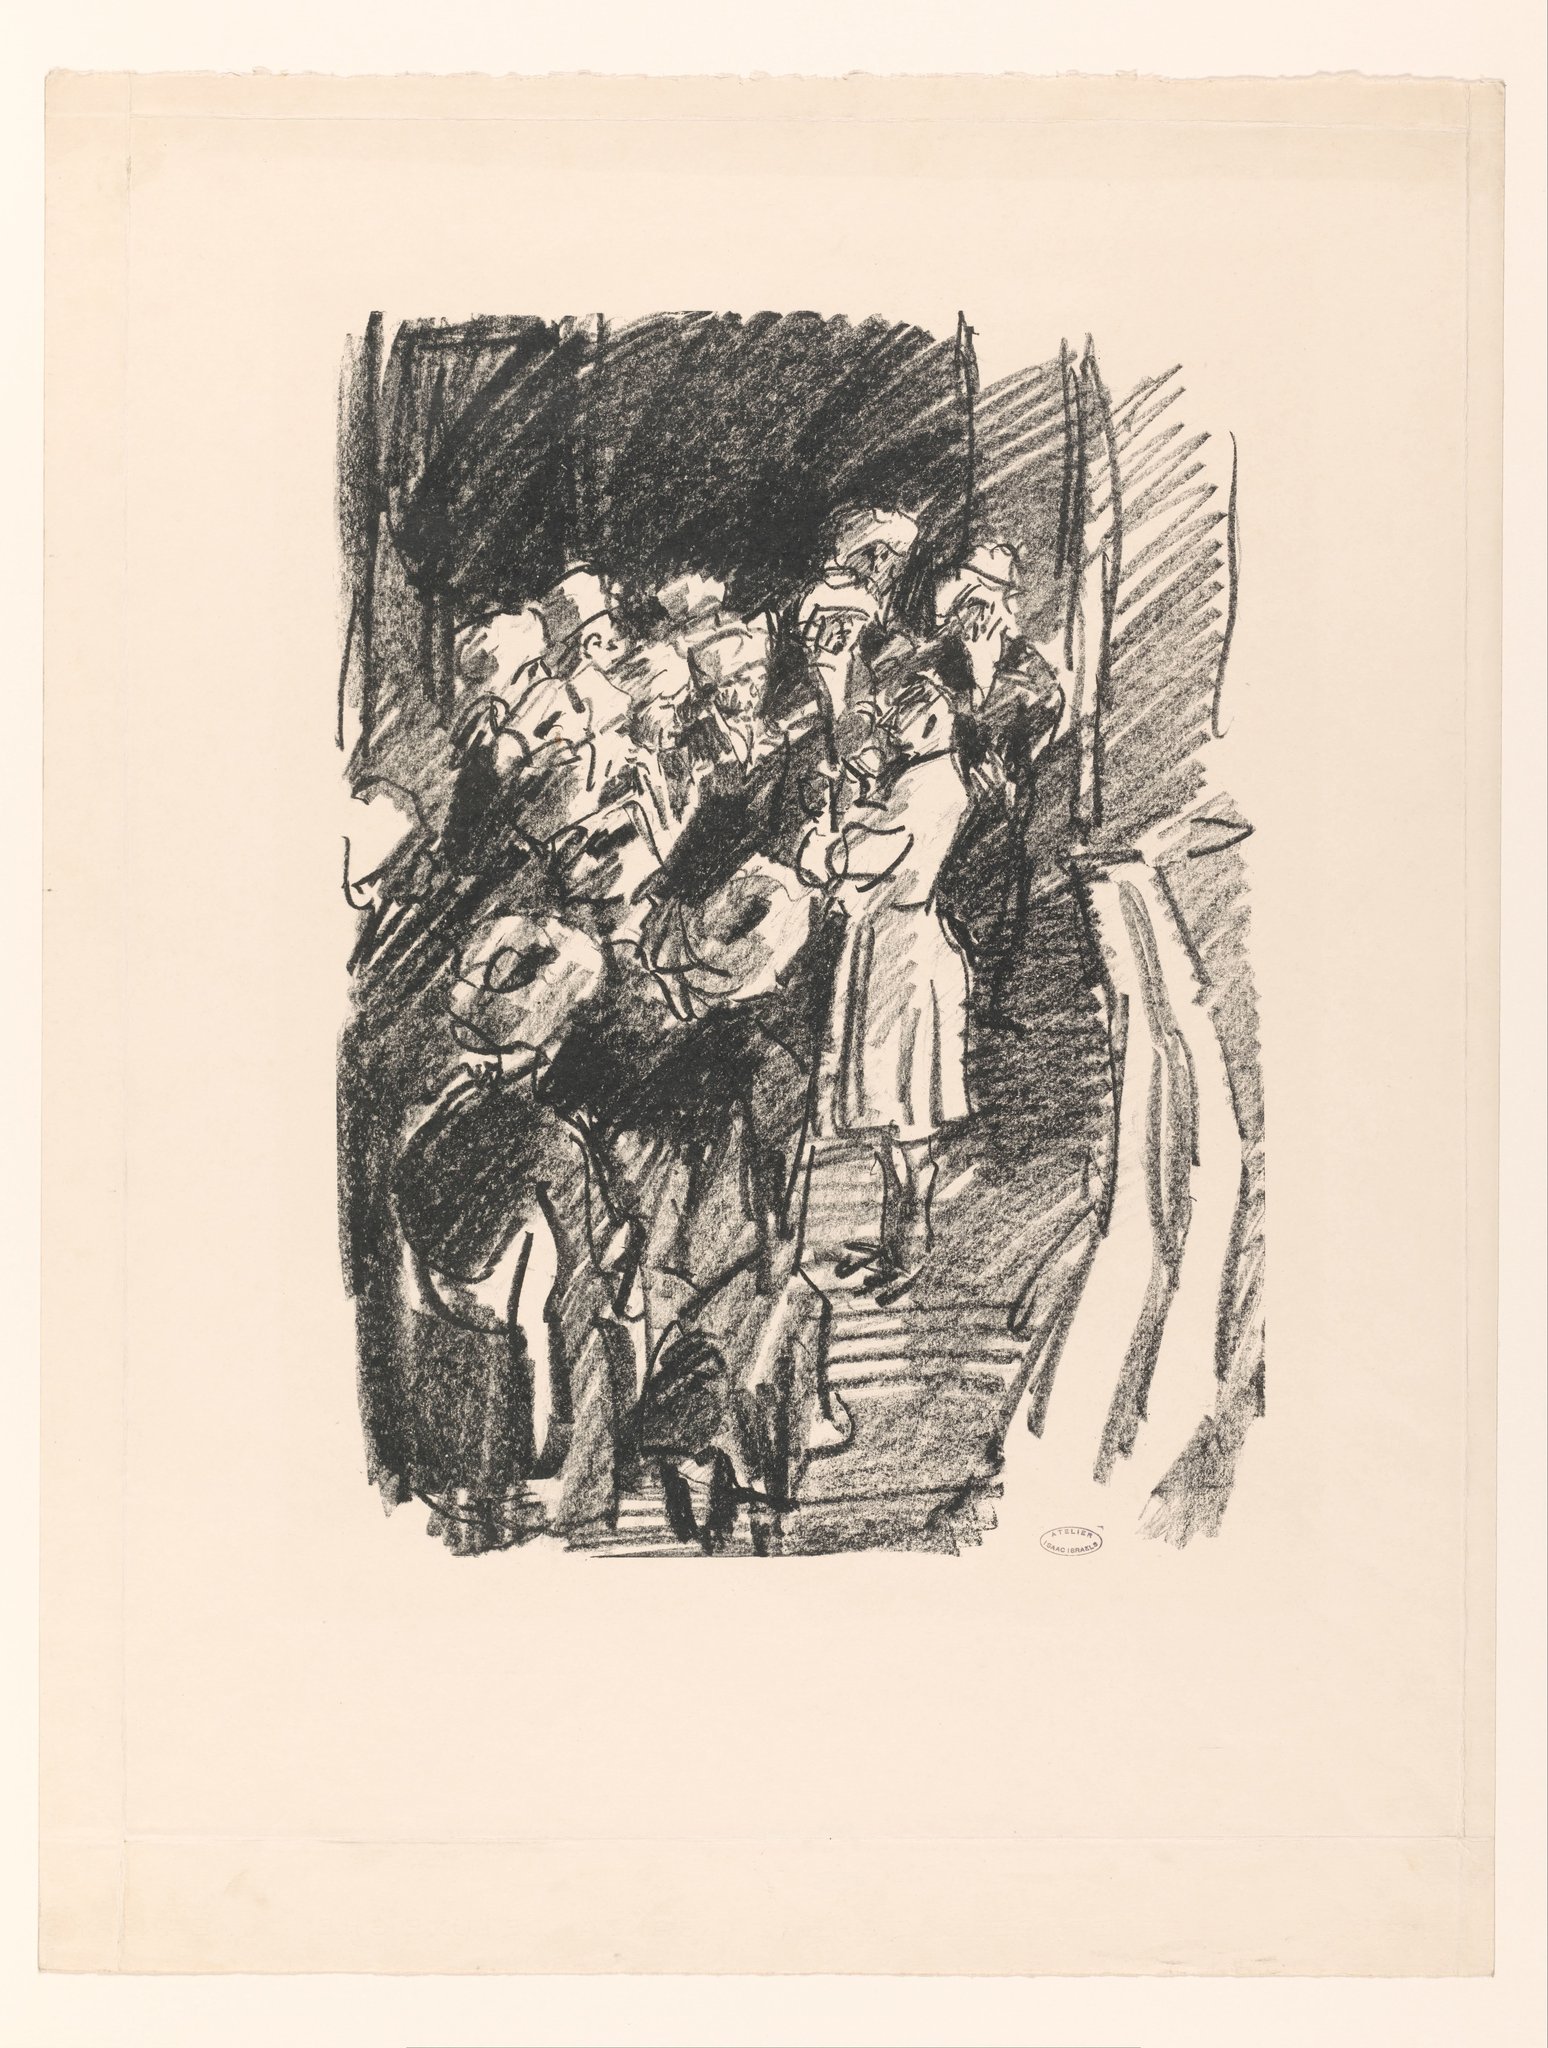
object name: print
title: Kozakkenkoor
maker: isaac israels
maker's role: draughtsman, painter, print maker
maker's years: 1865-1934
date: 1875-1934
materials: paper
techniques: lithograph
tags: choir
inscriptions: collector's mark: Lugt 2228, collector's mark: Lugt 1402a